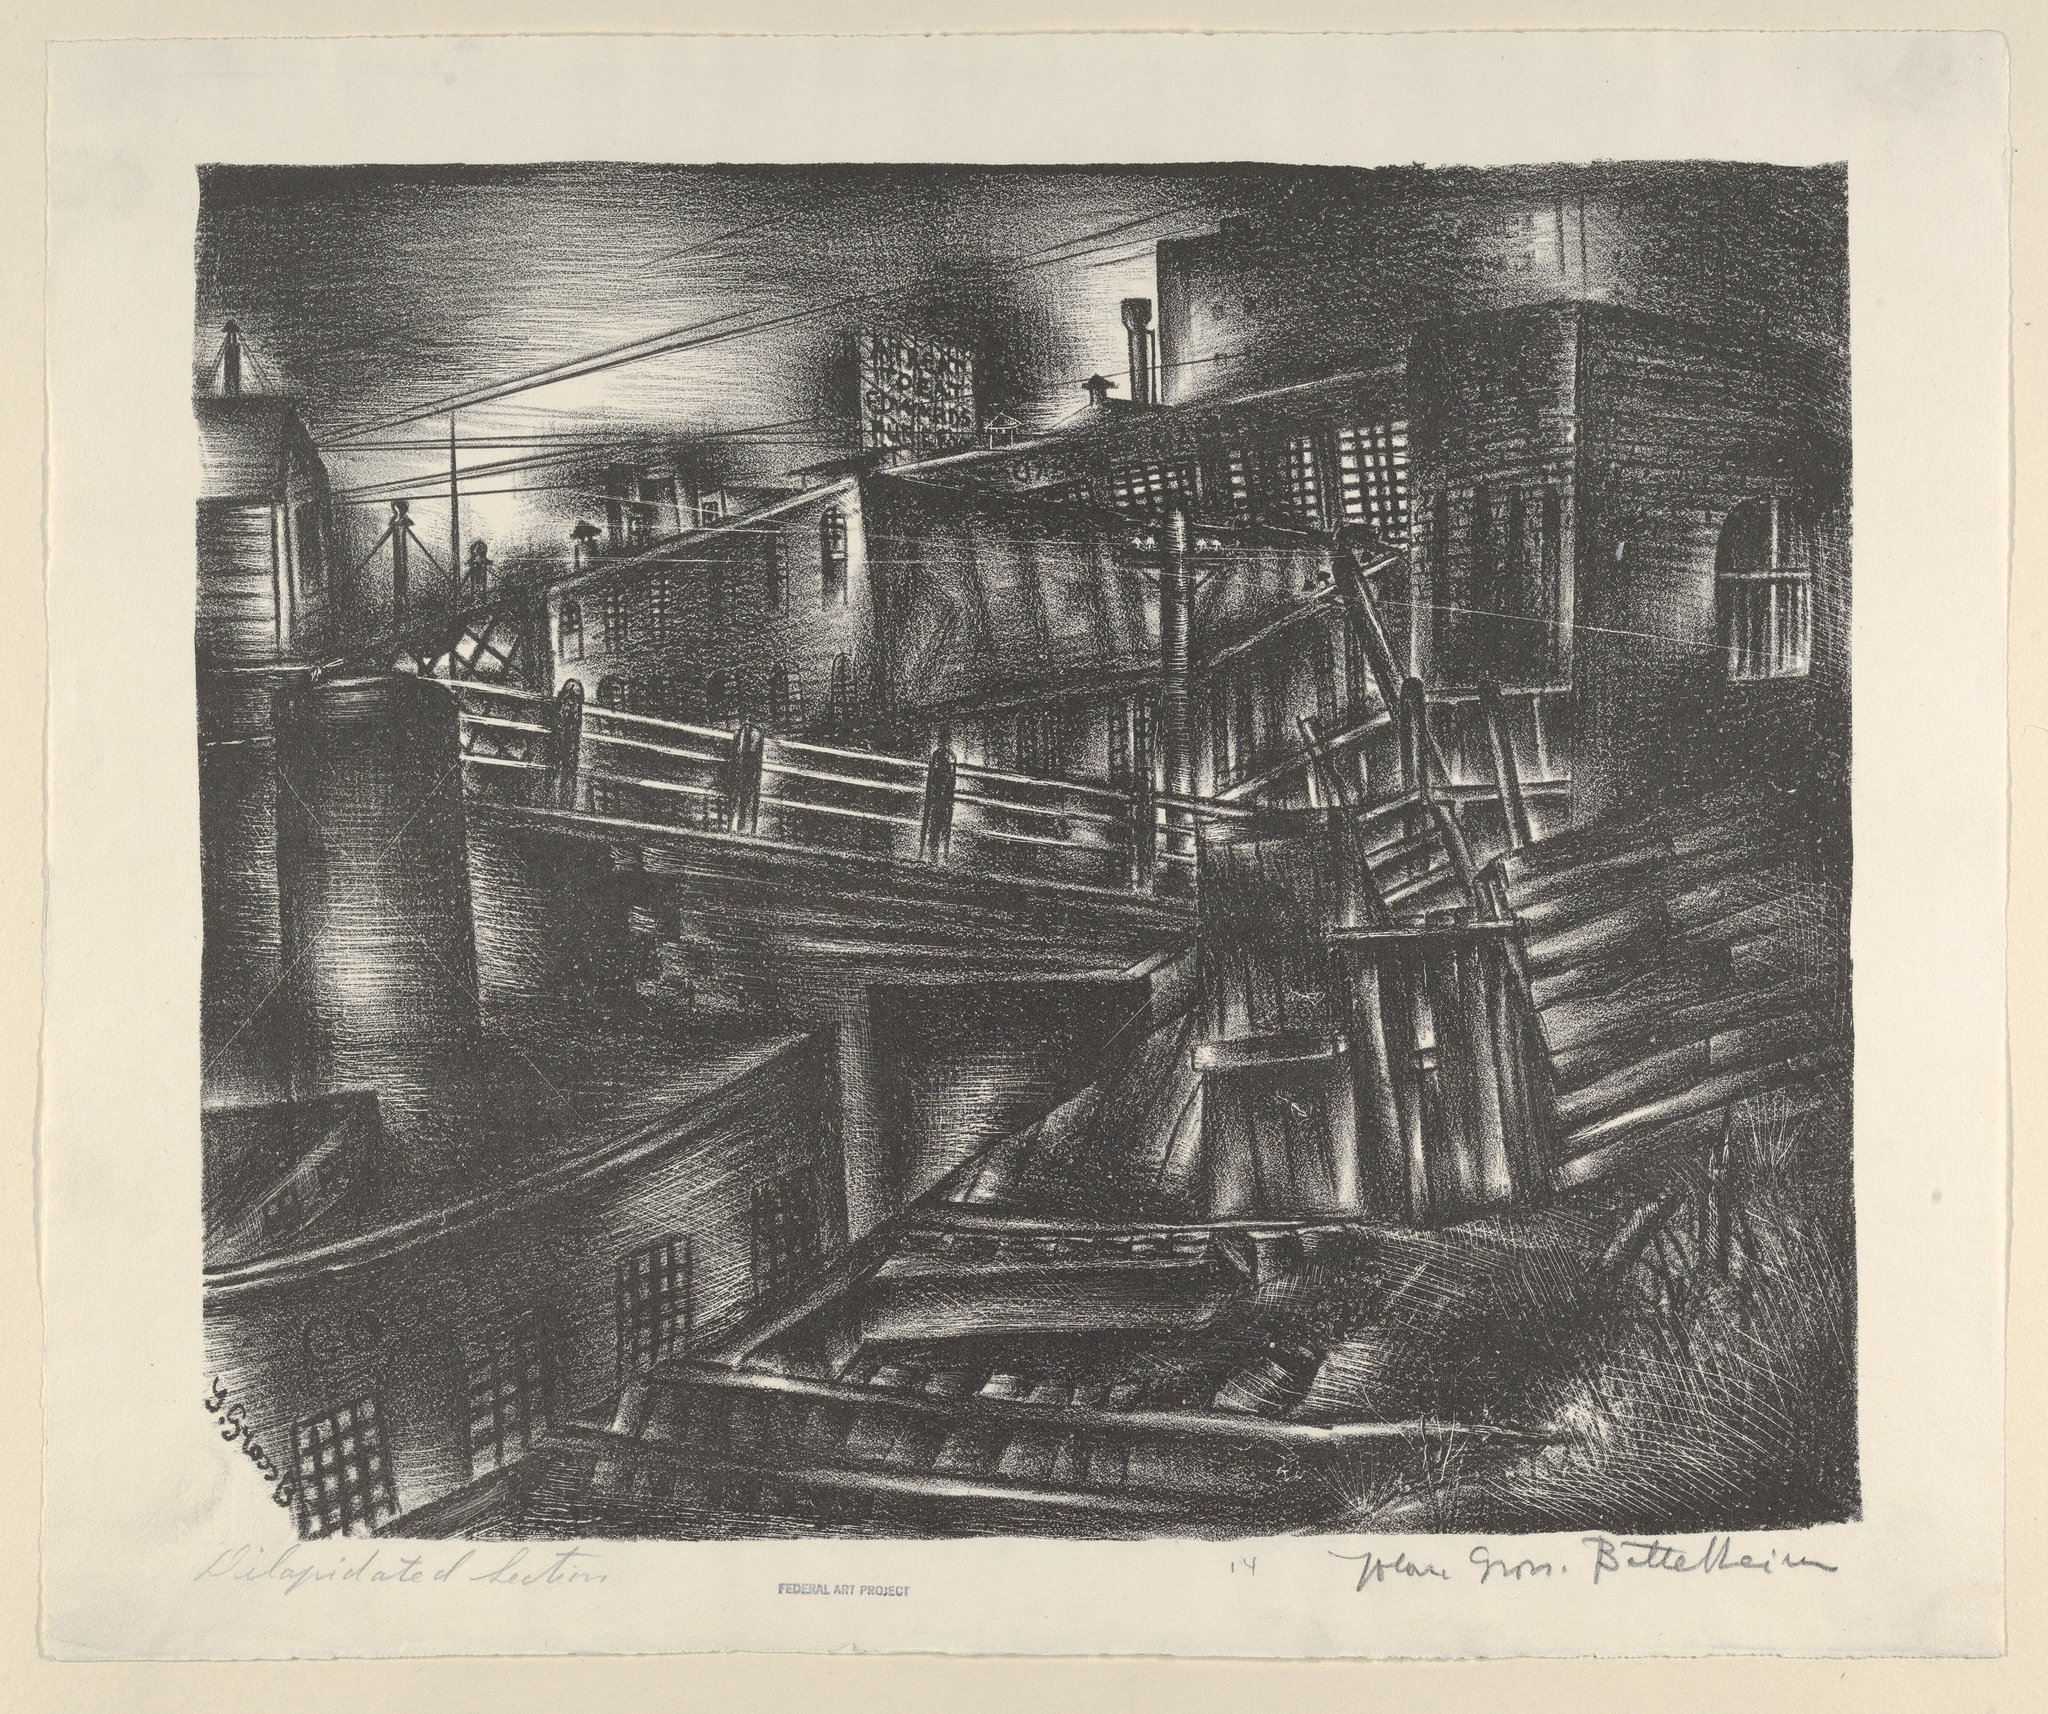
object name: print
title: Dilapidated Section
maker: jolan gross bettelheim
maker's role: artist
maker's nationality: american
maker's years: 1900-1972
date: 1935-1936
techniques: lithograph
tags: buildings